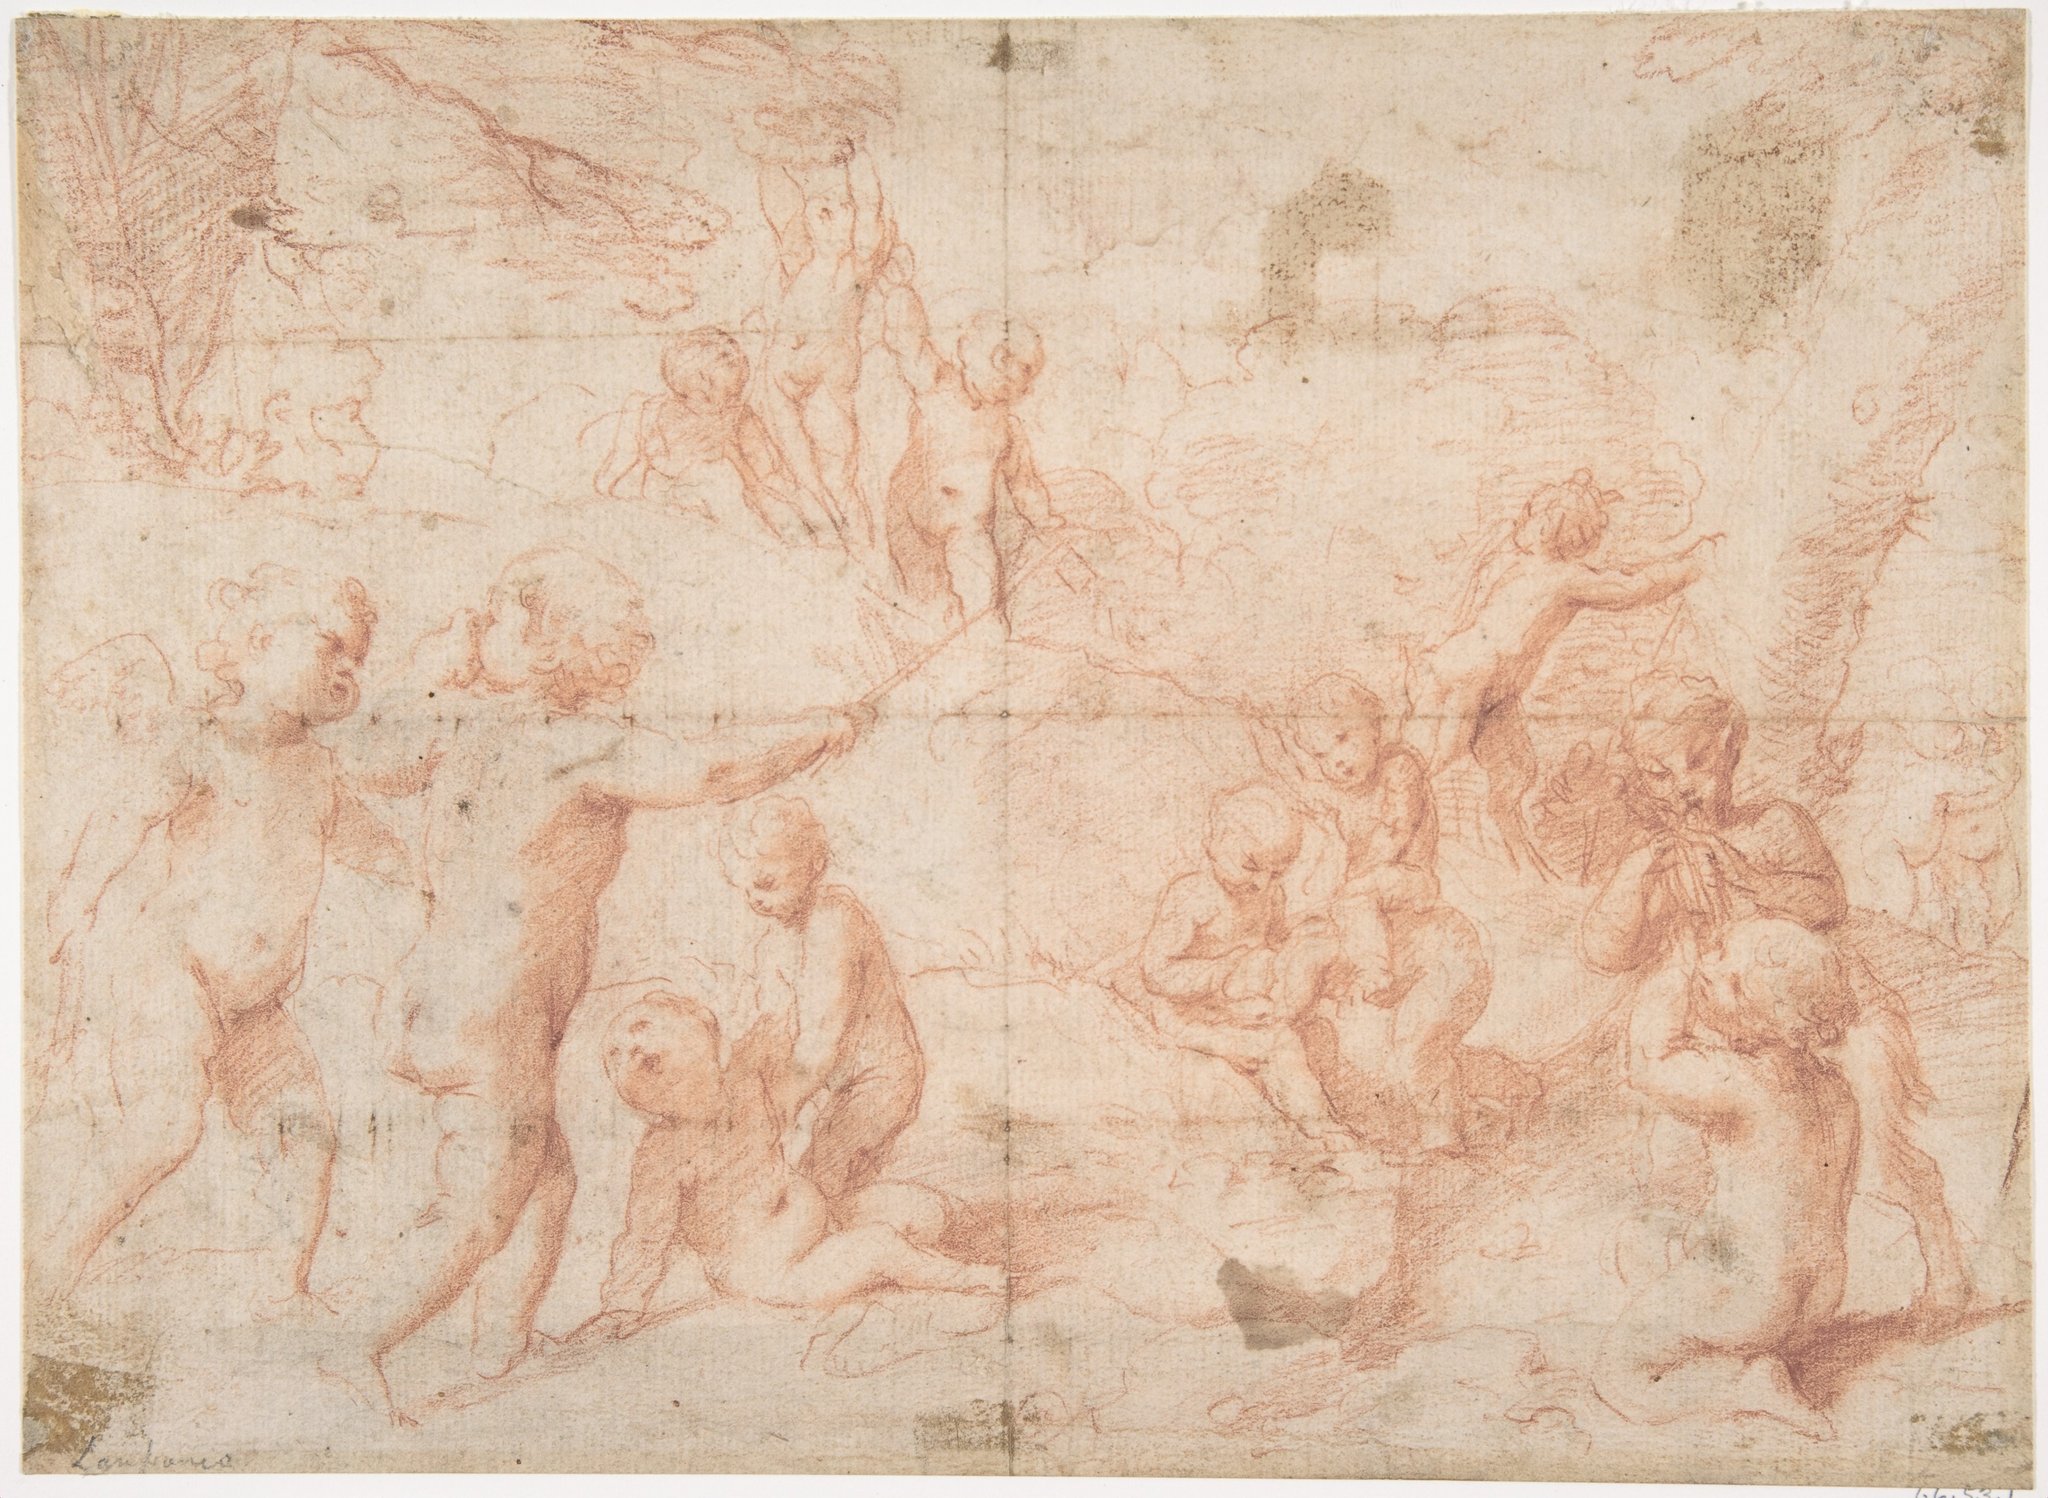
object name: drawing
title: Putti and a Young Satyr at Play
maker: giovanni lanfranco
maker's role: artist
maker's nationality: italian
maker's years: 1582-1647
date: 1582-1647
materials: chalk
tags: playing,putti,satyrs